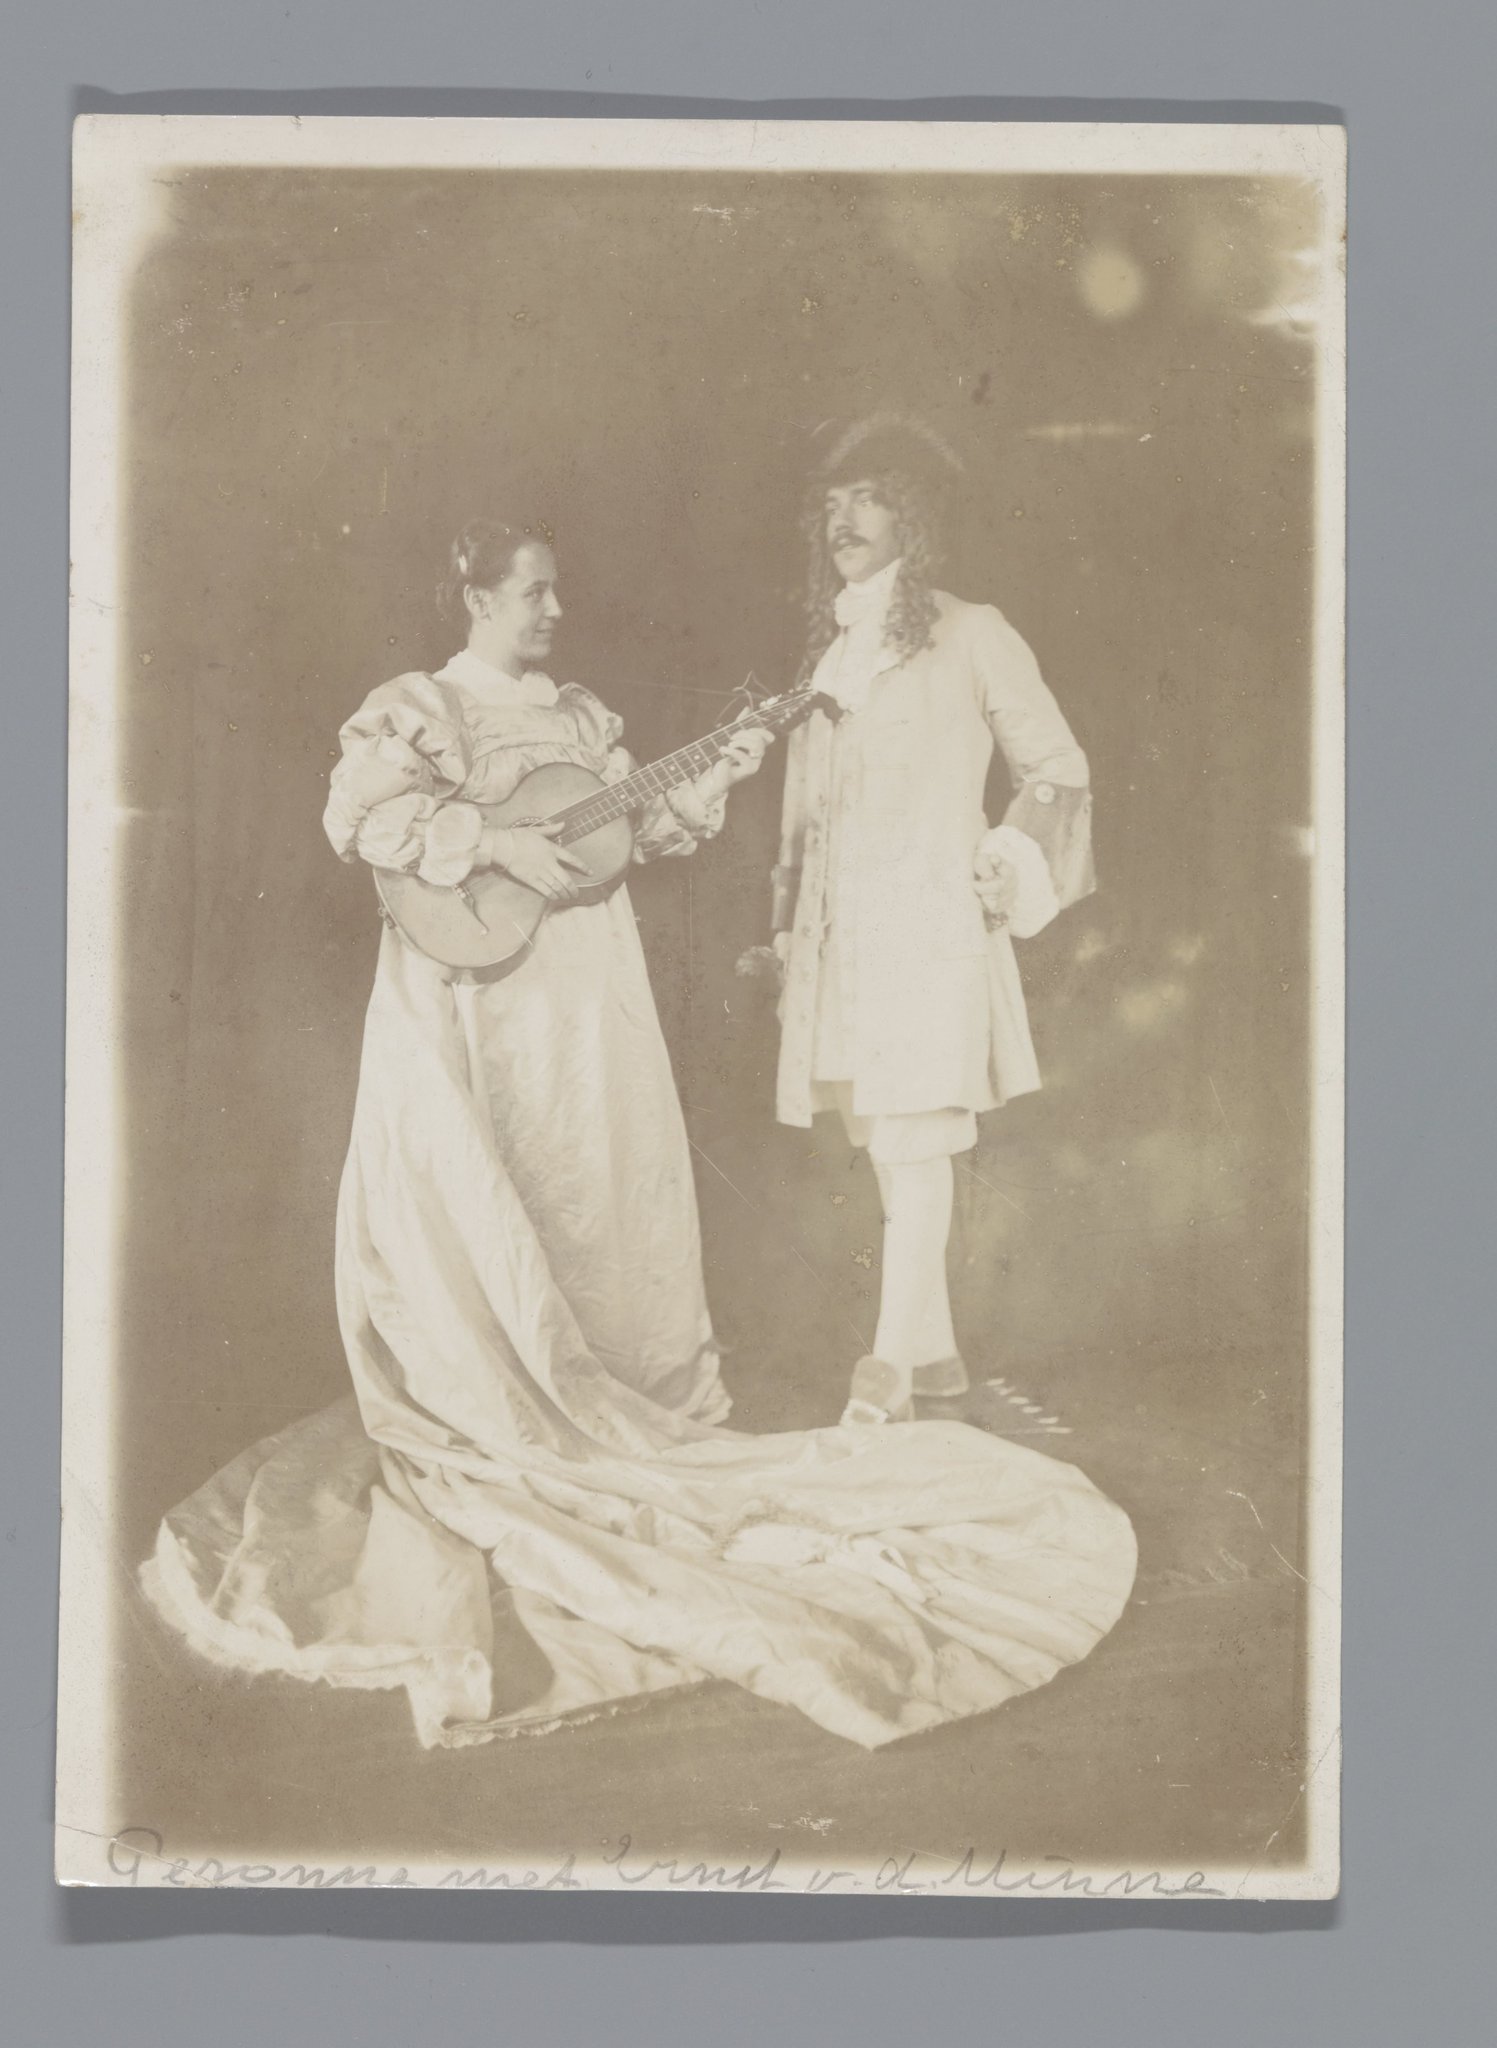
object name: photograph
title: Peronne en Ernst v/d Minne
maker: willem witsen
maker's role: draughtsman, painter, print maker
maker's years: 1860-1923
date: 1860-1915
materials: paper, photographic support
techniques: gelatin silver print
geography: amsterdam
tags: the hague, ernst van der minne